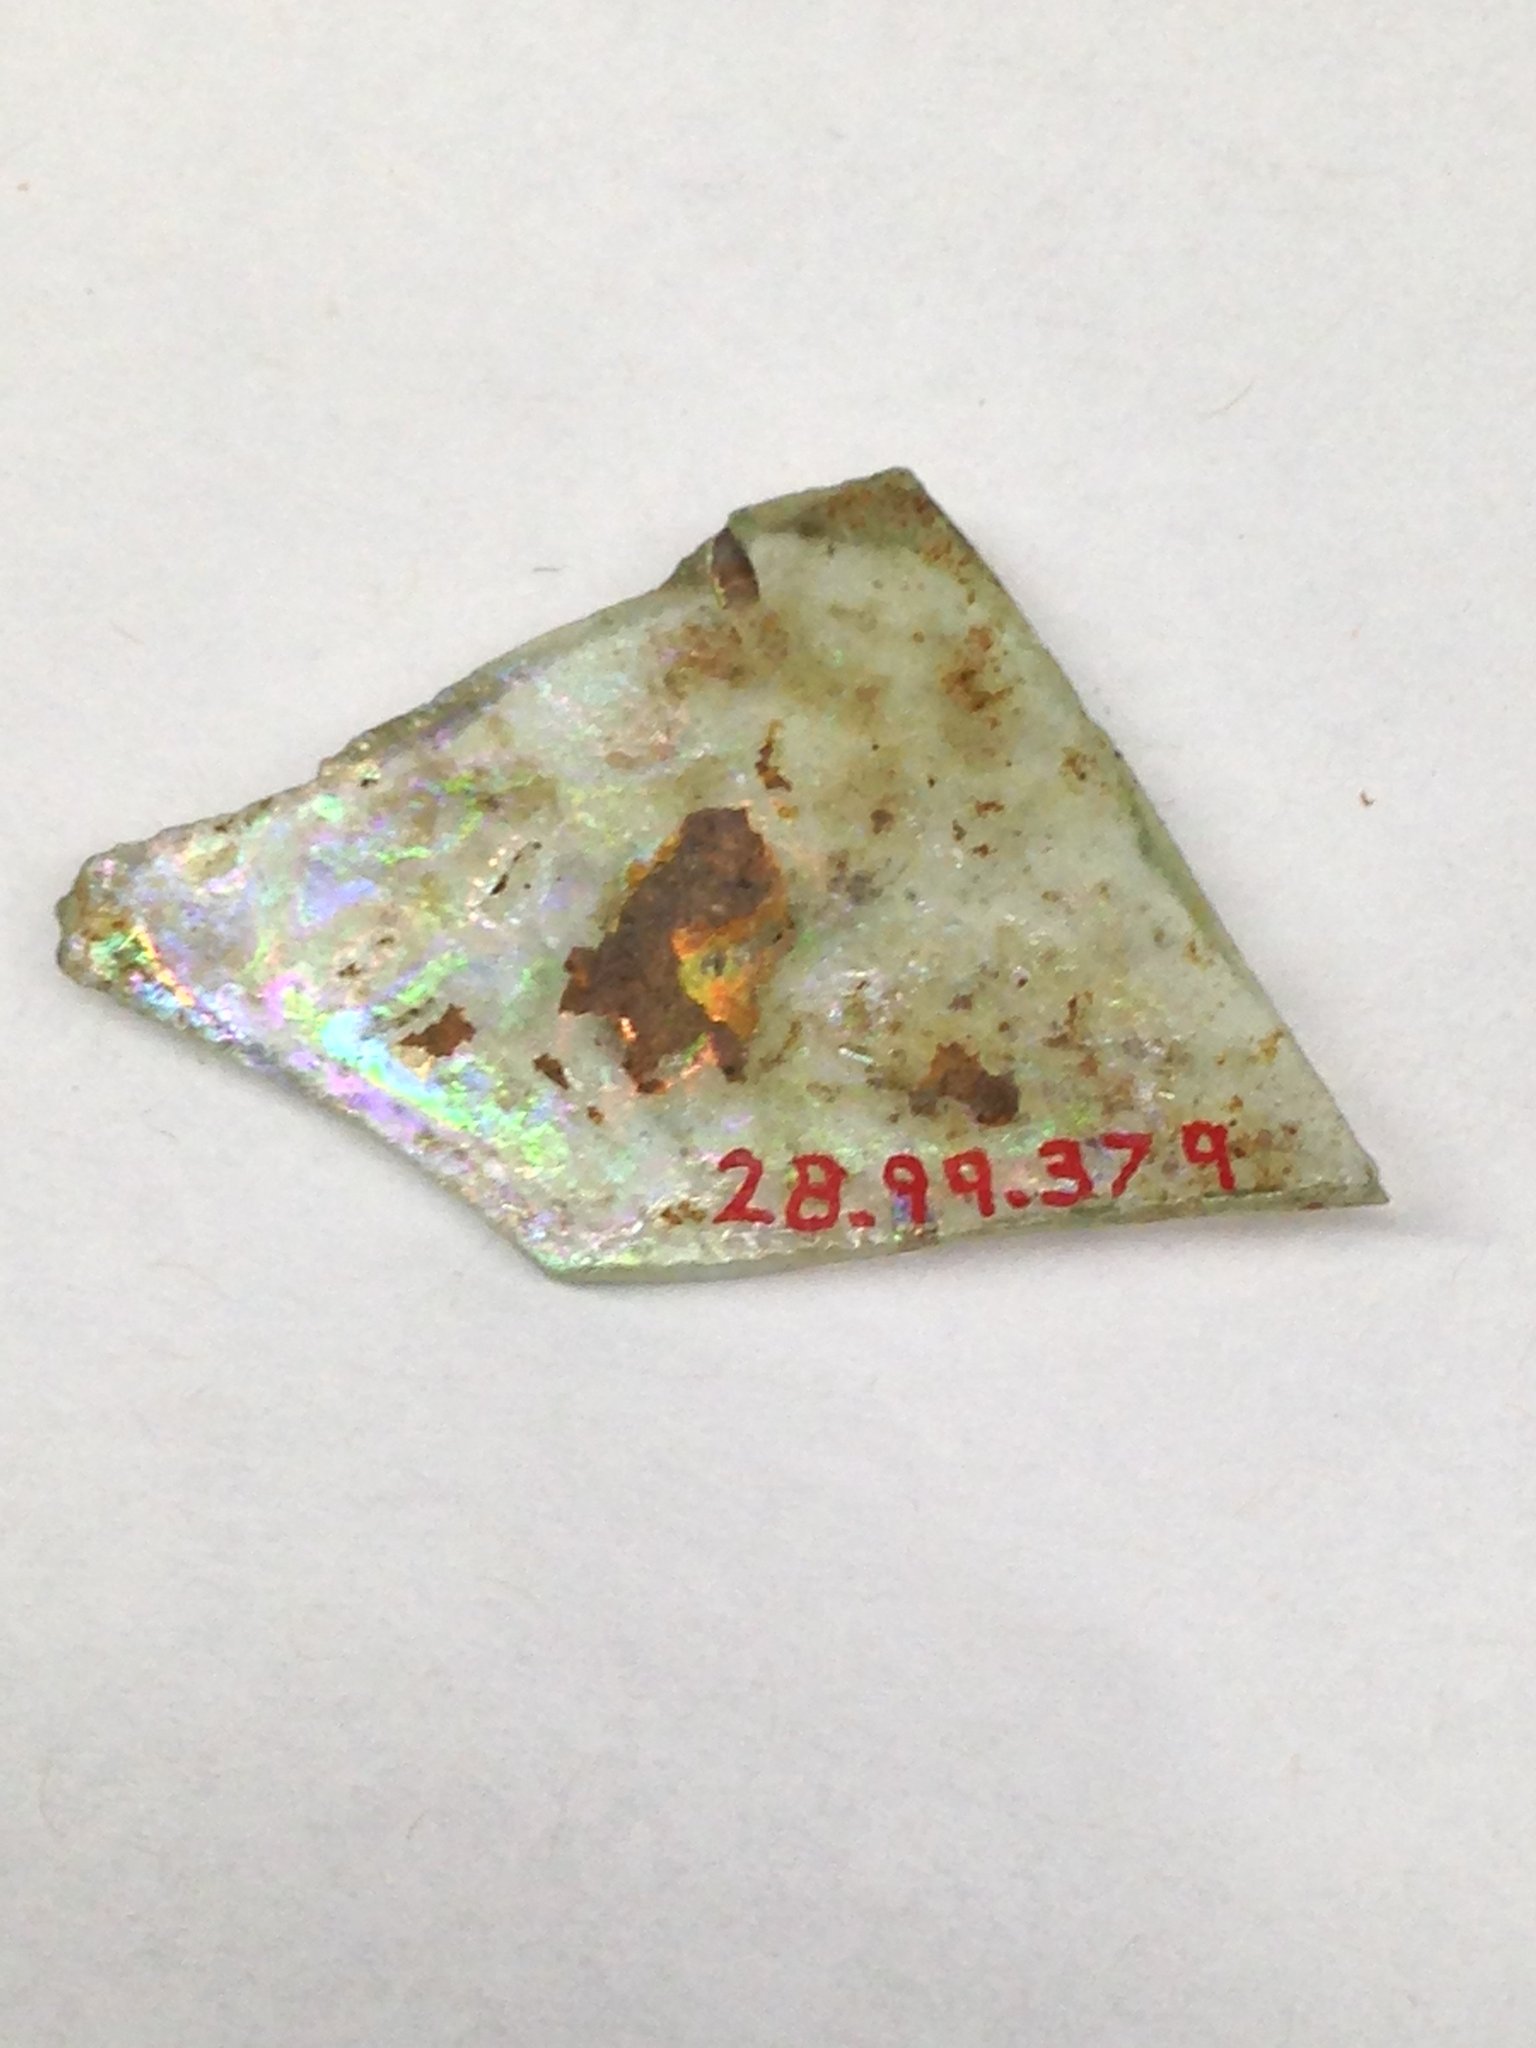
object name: fragment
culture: european or middle eastern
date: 1150-1250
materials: ceramic, glass